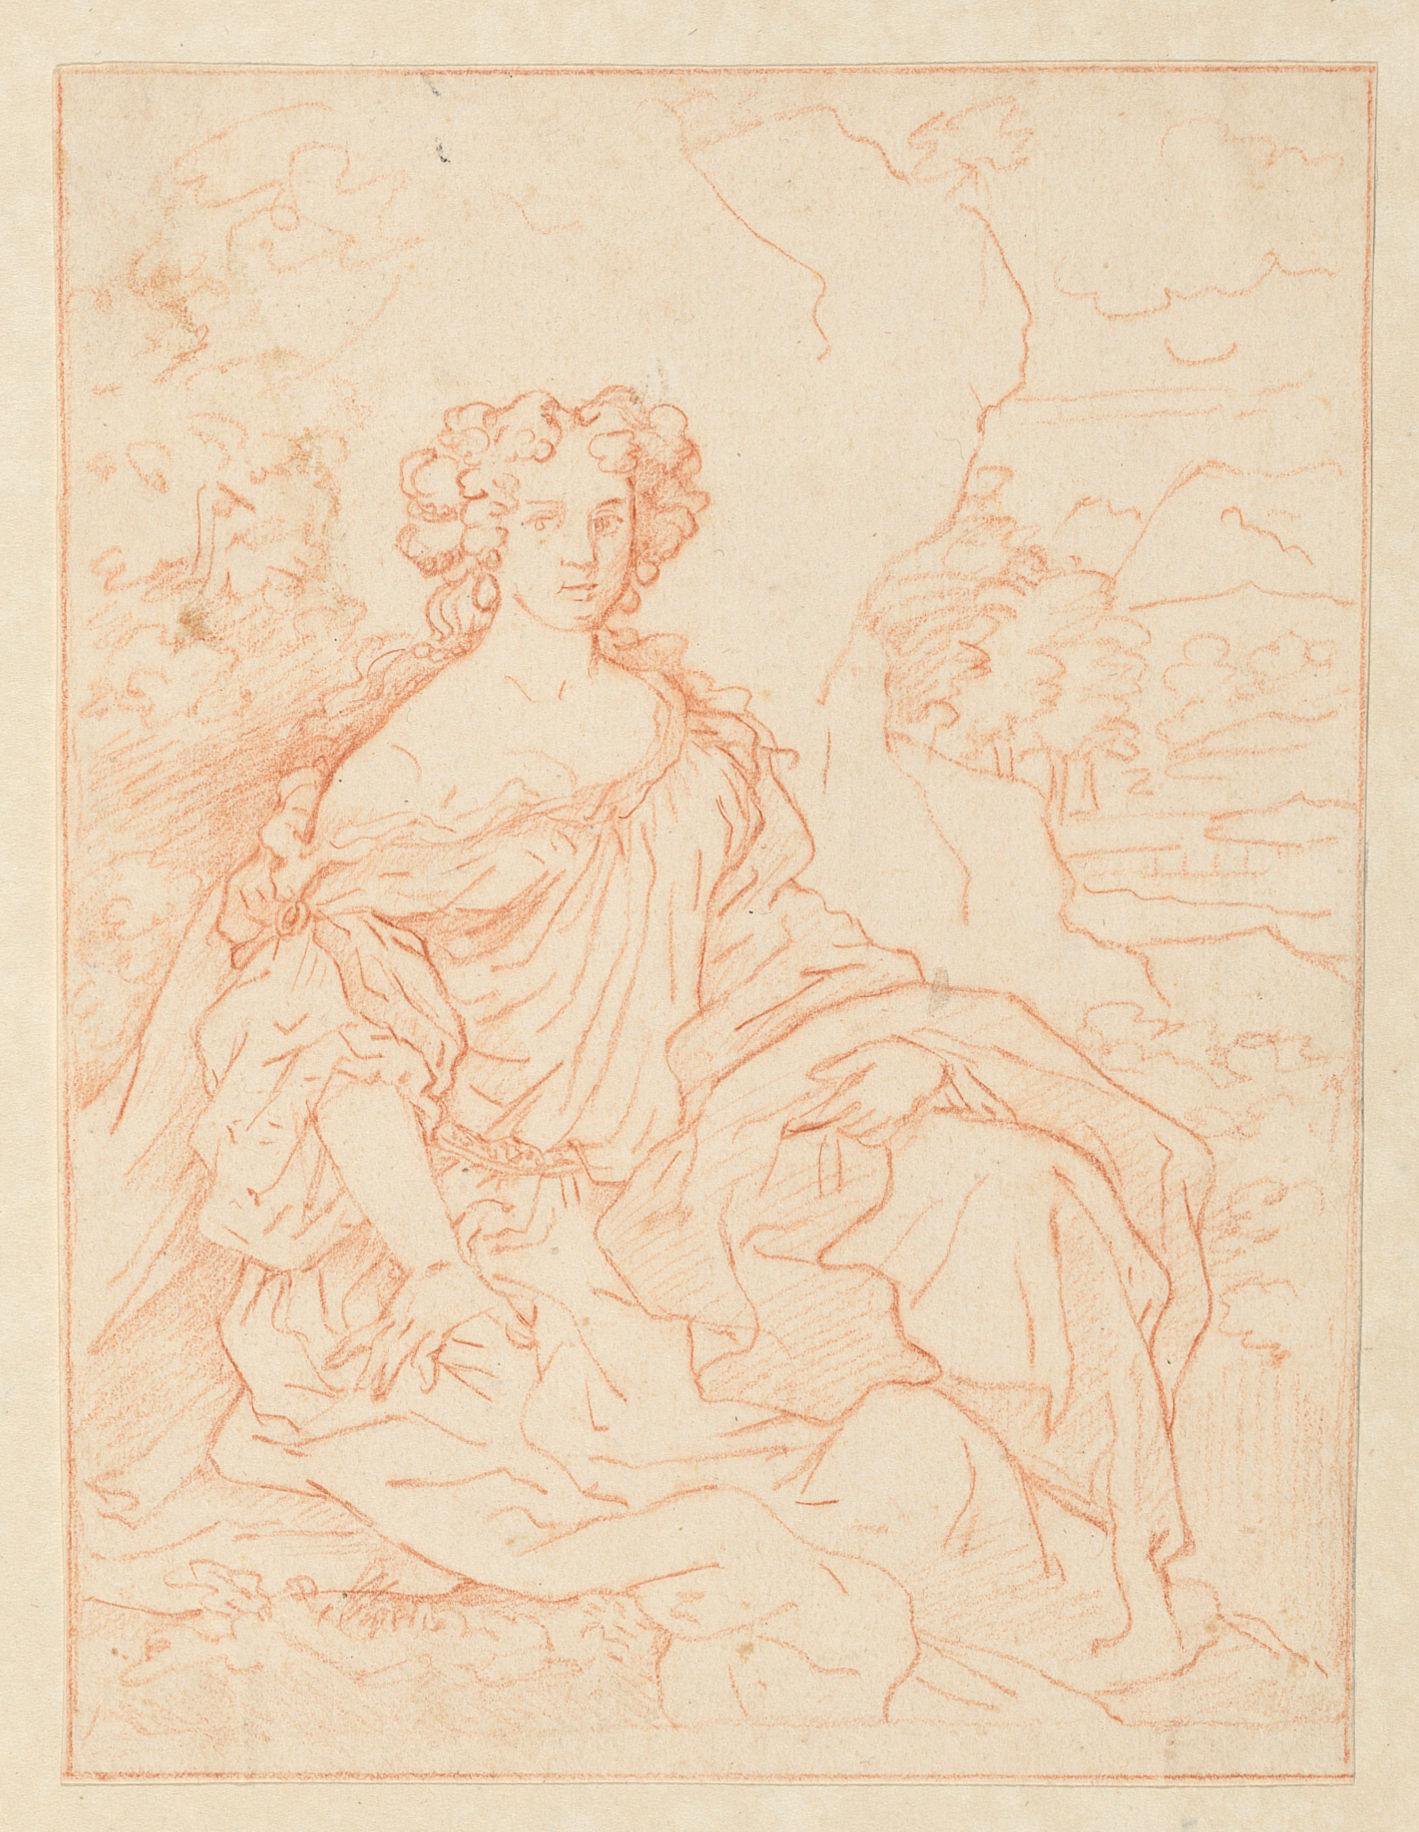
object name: drawing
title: Portret van een zittende vrouw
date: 1649-1723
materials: chalk, paper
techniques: pasting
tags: landscapes, historical persons not known by name - bb - woman